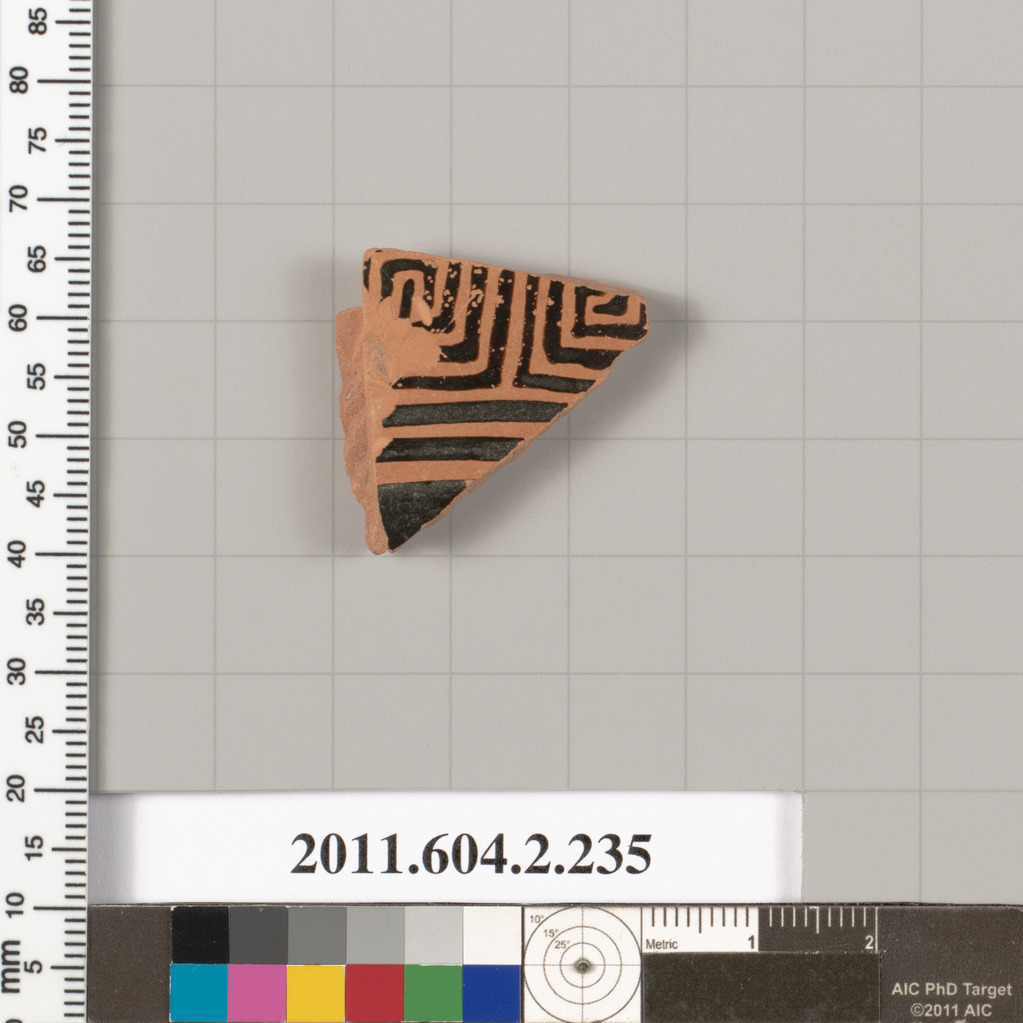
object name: stamnos fragment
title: Terracotta fragment of a stamnos (jar)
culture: greek, attic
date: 460-440 BCE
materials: terracotta